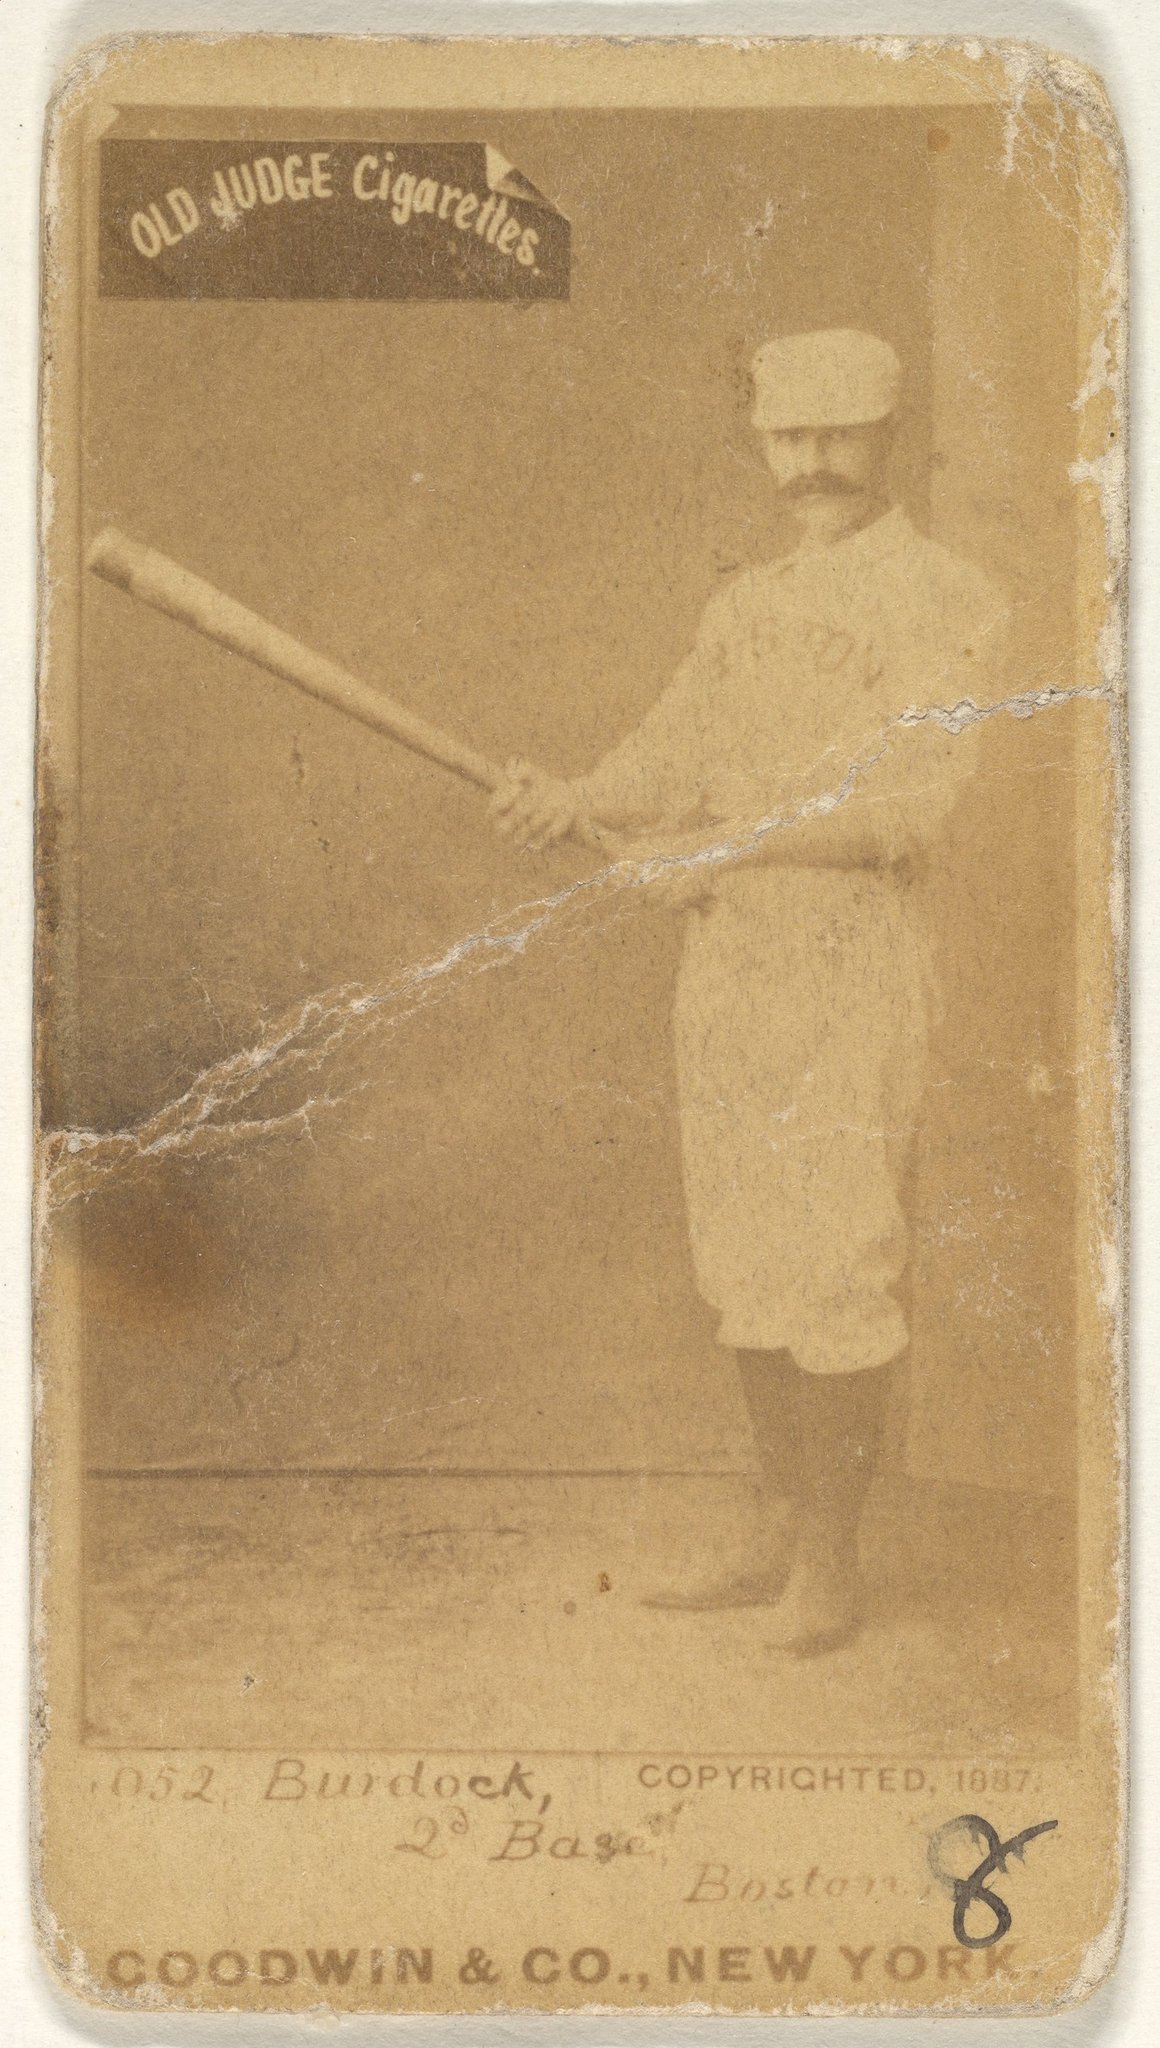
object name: baseball card, photograph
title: Burdock, 2nd Base, Boston, from the Old Judge series (N172) for Old Judge Cigarettes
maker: goodwin & company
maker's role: publisher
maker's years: 1850-1950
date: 1887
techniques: albumen silver print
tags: men,portraits,baseball,athletes